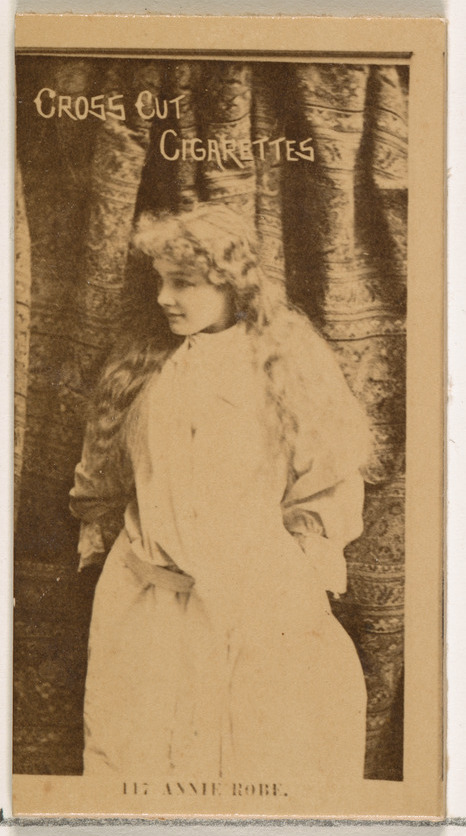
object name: print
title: Card Number 117, Annie Robe, from the Actors and Actresses series (N145-2) issued by Duke Sons & Co. to promote Cross Cut Cigarettes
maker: w. duke, sons & co.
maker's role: publisher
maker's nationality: american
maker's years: 1870-1920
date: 1880-1889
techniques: albumen silver print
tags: portraits,women,actresses